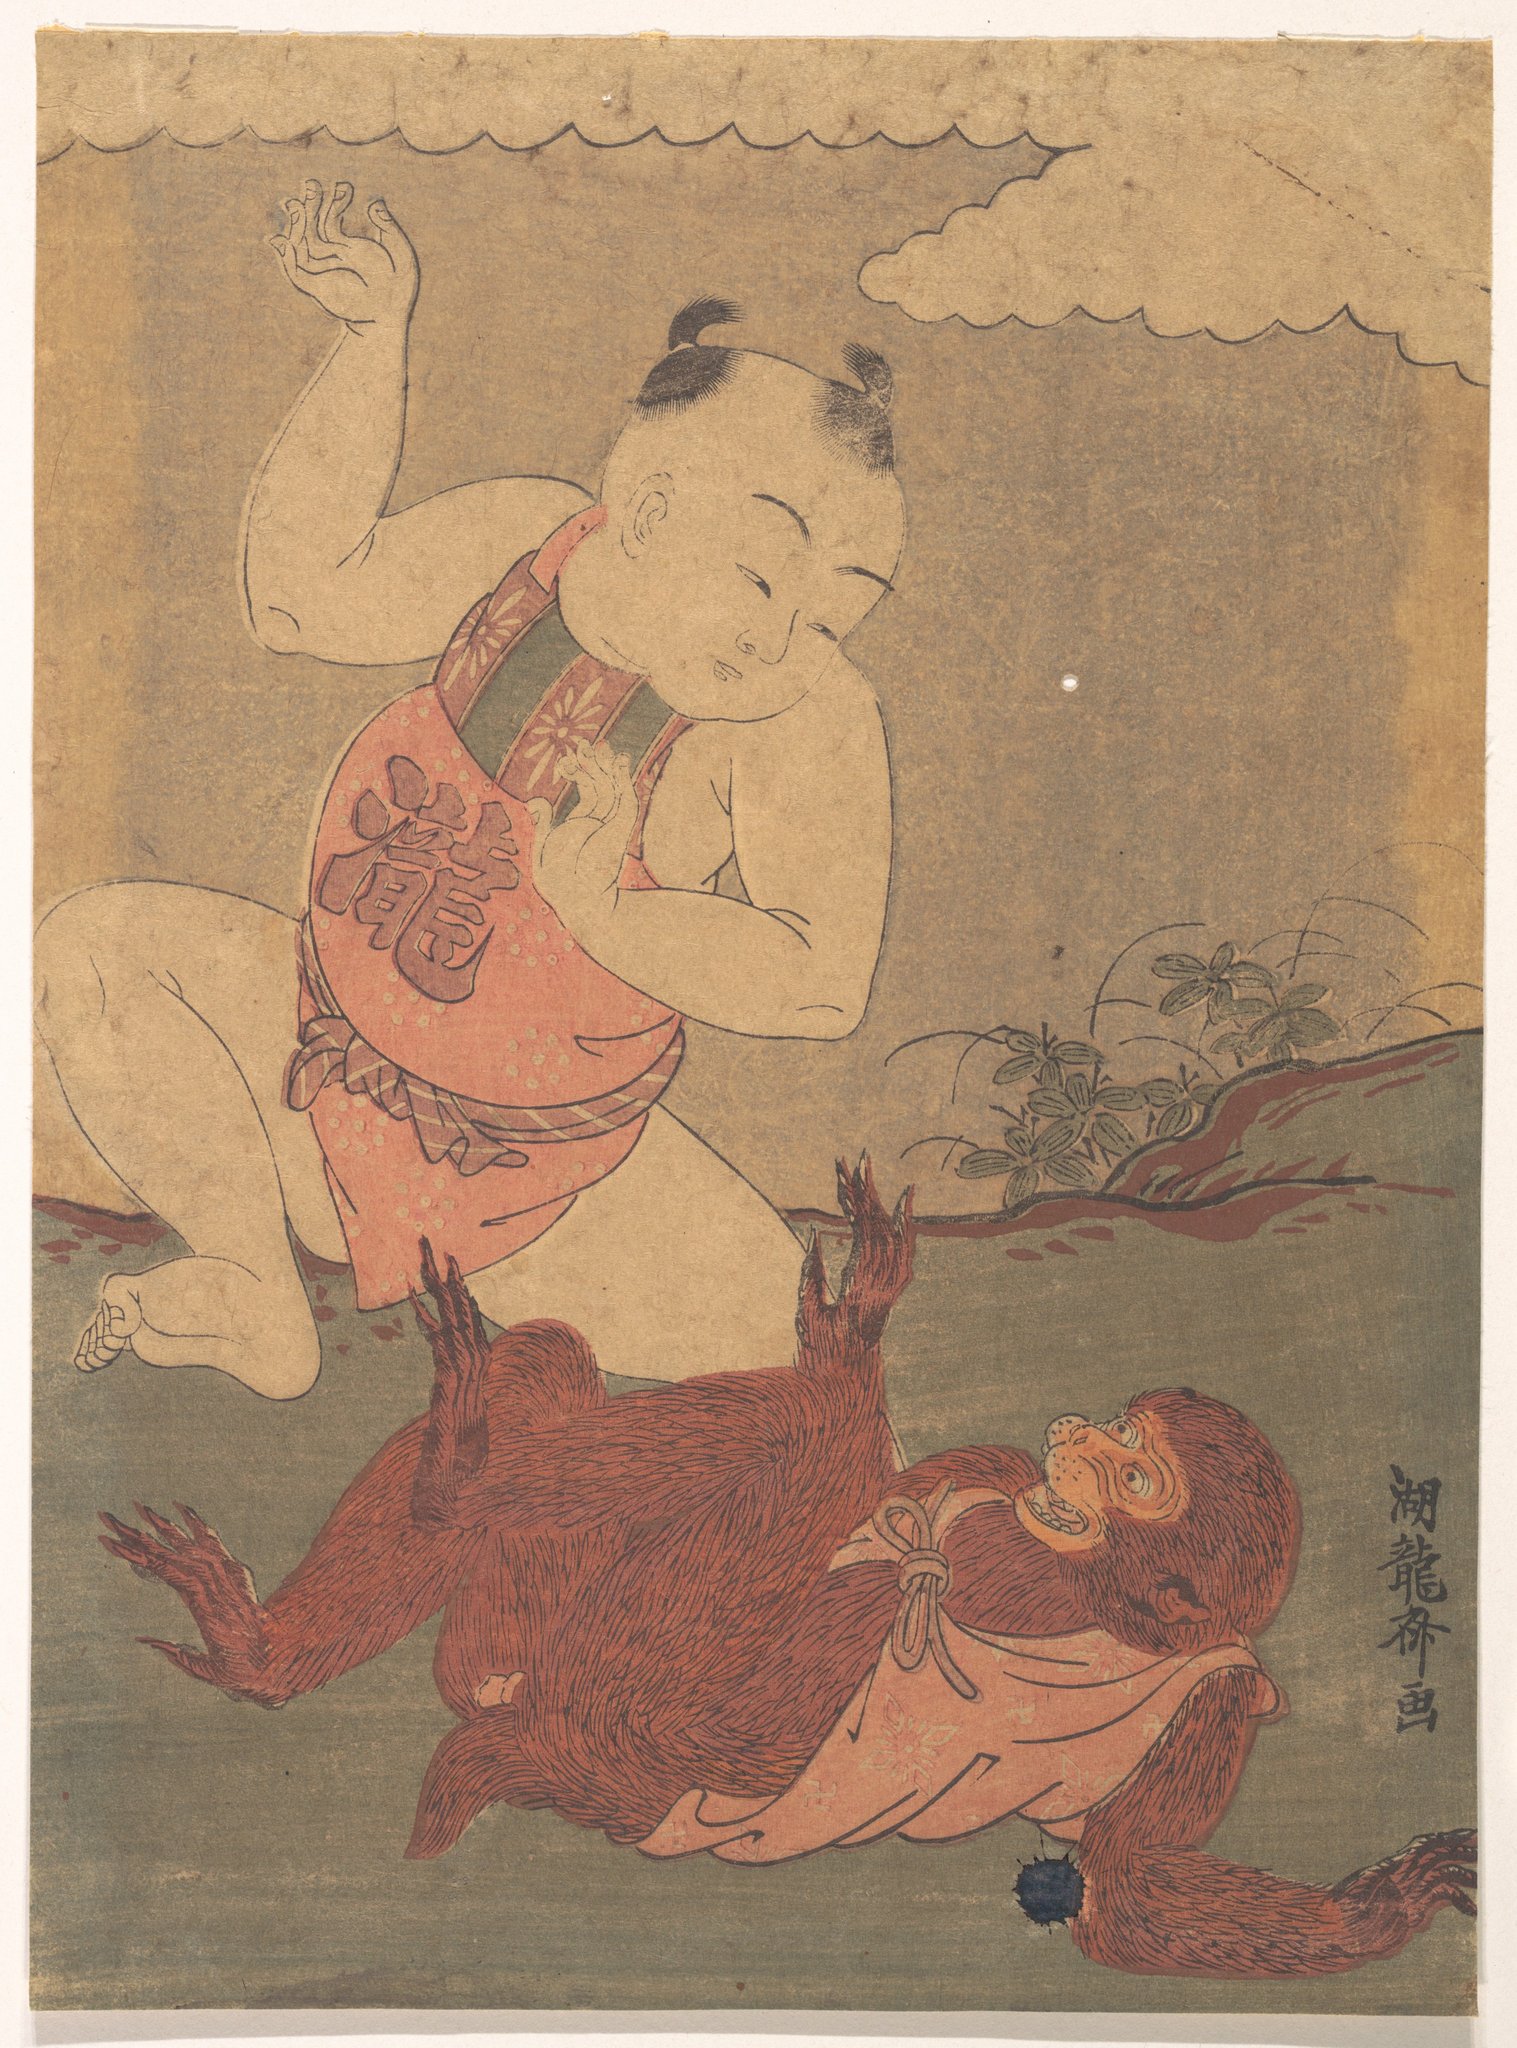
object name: print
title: Boy and Monkey Playing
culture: japanese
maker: isoda koryūsai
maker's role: artist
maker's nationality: japanese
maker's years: 1735-1790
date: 1770-1790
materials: ink, paper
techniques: woodblock print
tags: boys,playing,monkeys